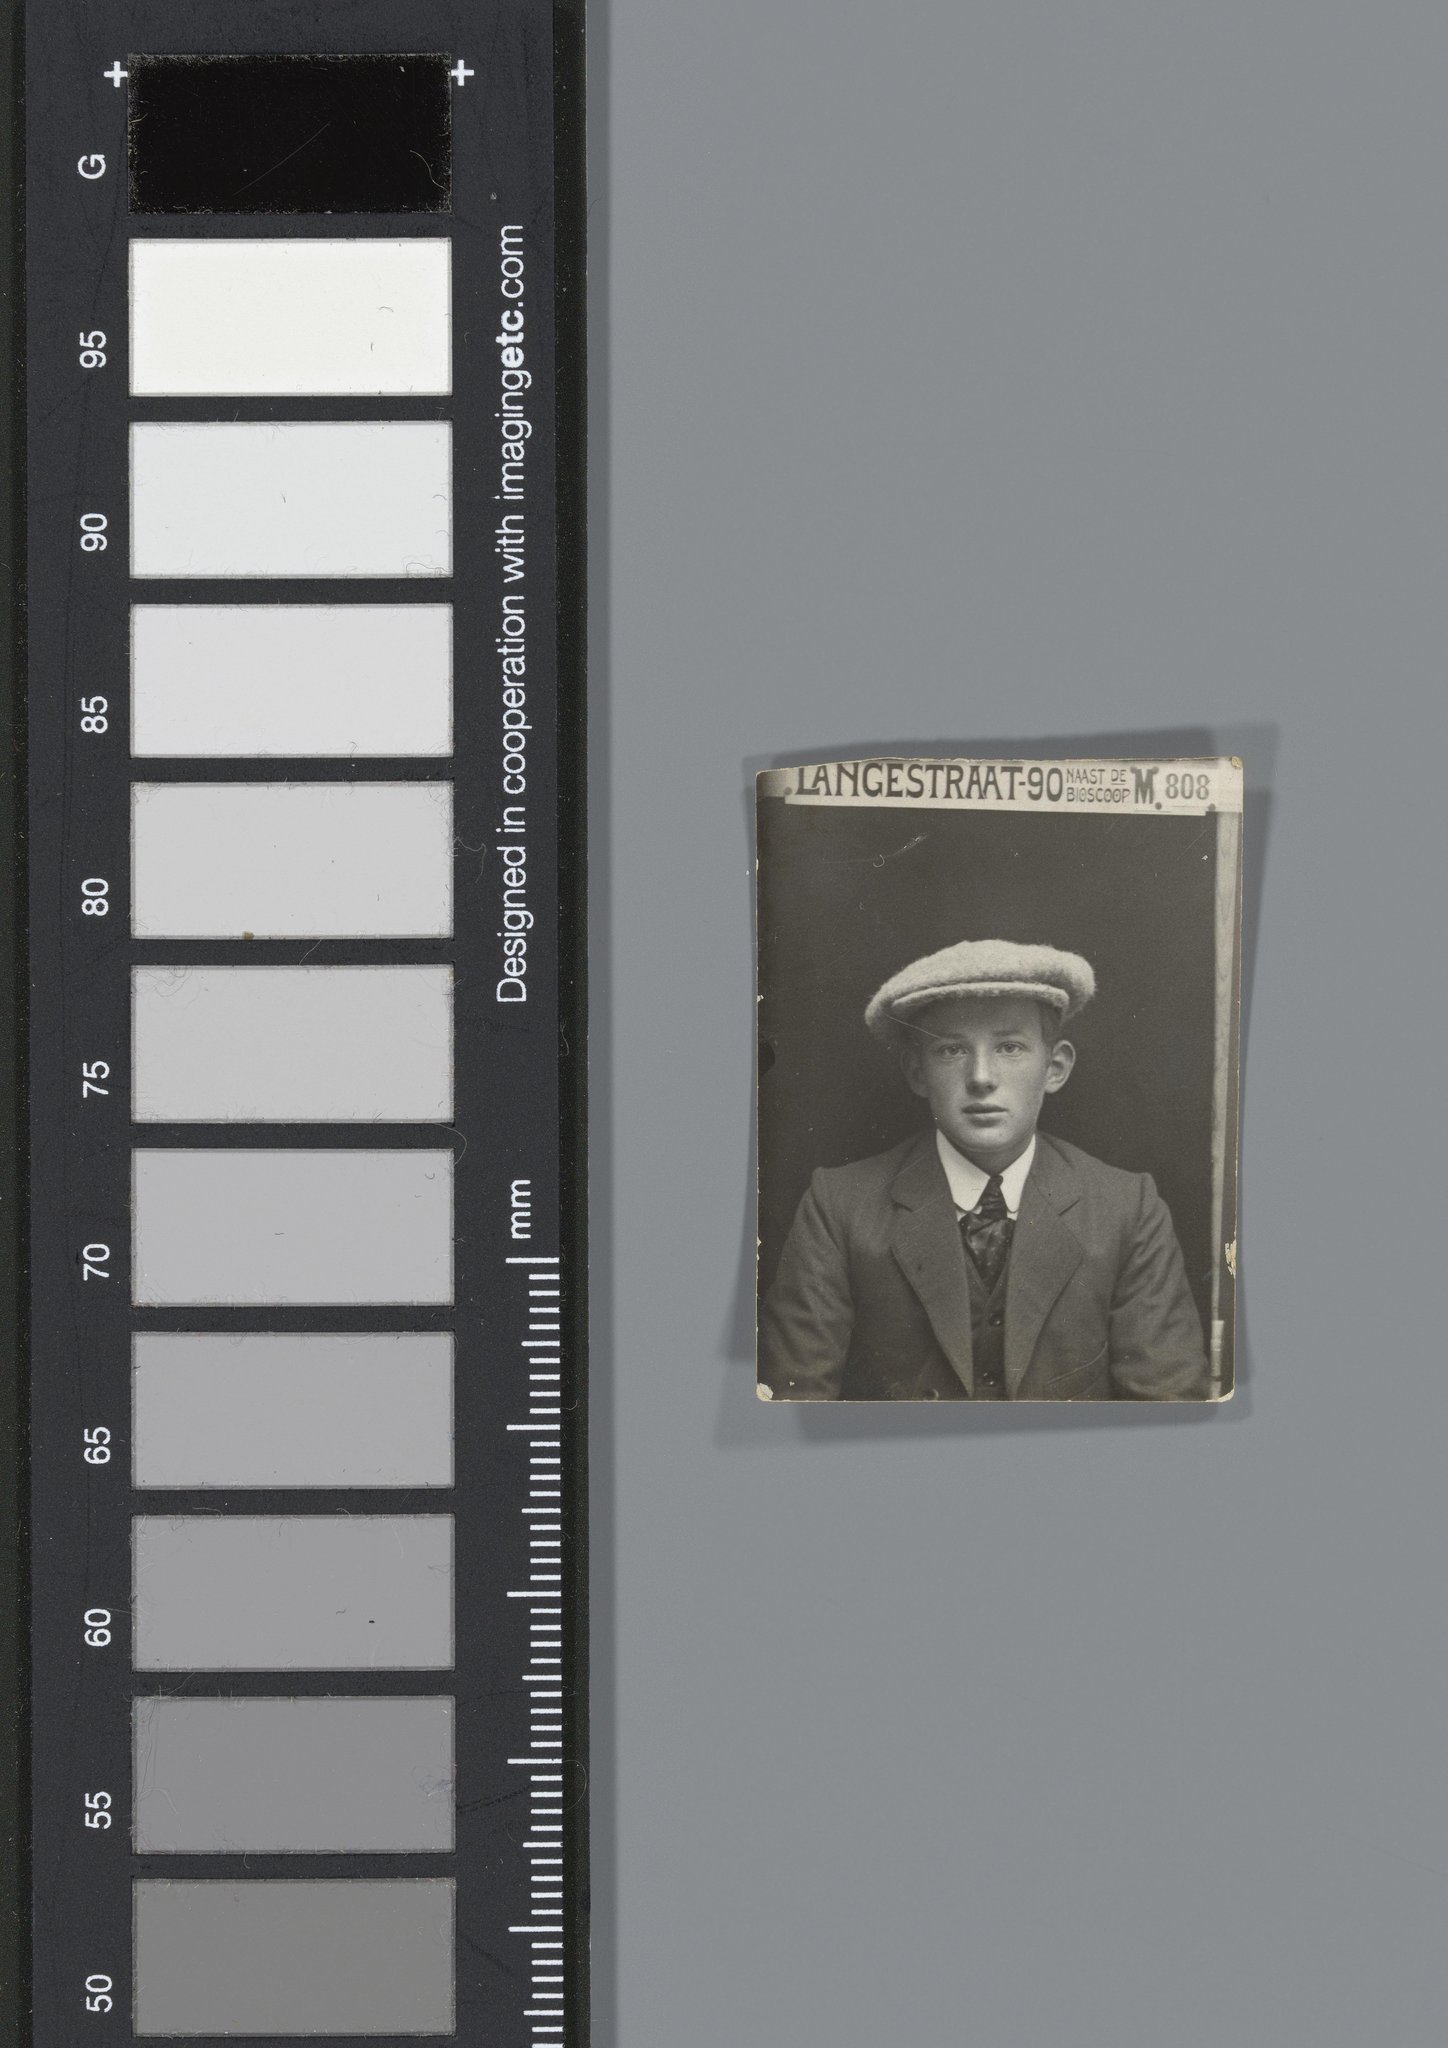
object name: snapshot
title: Rapid photographs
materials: photographic support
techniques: gelatin silver print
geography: alkmaar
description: Between 1912 and 1930, anyone could have their portrait taken at the many so-called rapid photography studios in the shopping streets of mainly (medium) large-size European cities. As if on an assembly line, the youngest clerk shot the photographs with a special camera and in artificial light and developed them. Later in the day, the customer collected a sheet with 12 portrait photos for 25 cents. This form of photographic mass production gave rise to a fascinating tableau of boys, girls, men and women not previously seen in photographs; candid and informal. There were at least 150 quick-photo studios, from Alkmaar to Zutphen. Many called themselves ‘American,’ mistakenly as it turns out because hardly any examples from that country have been found.